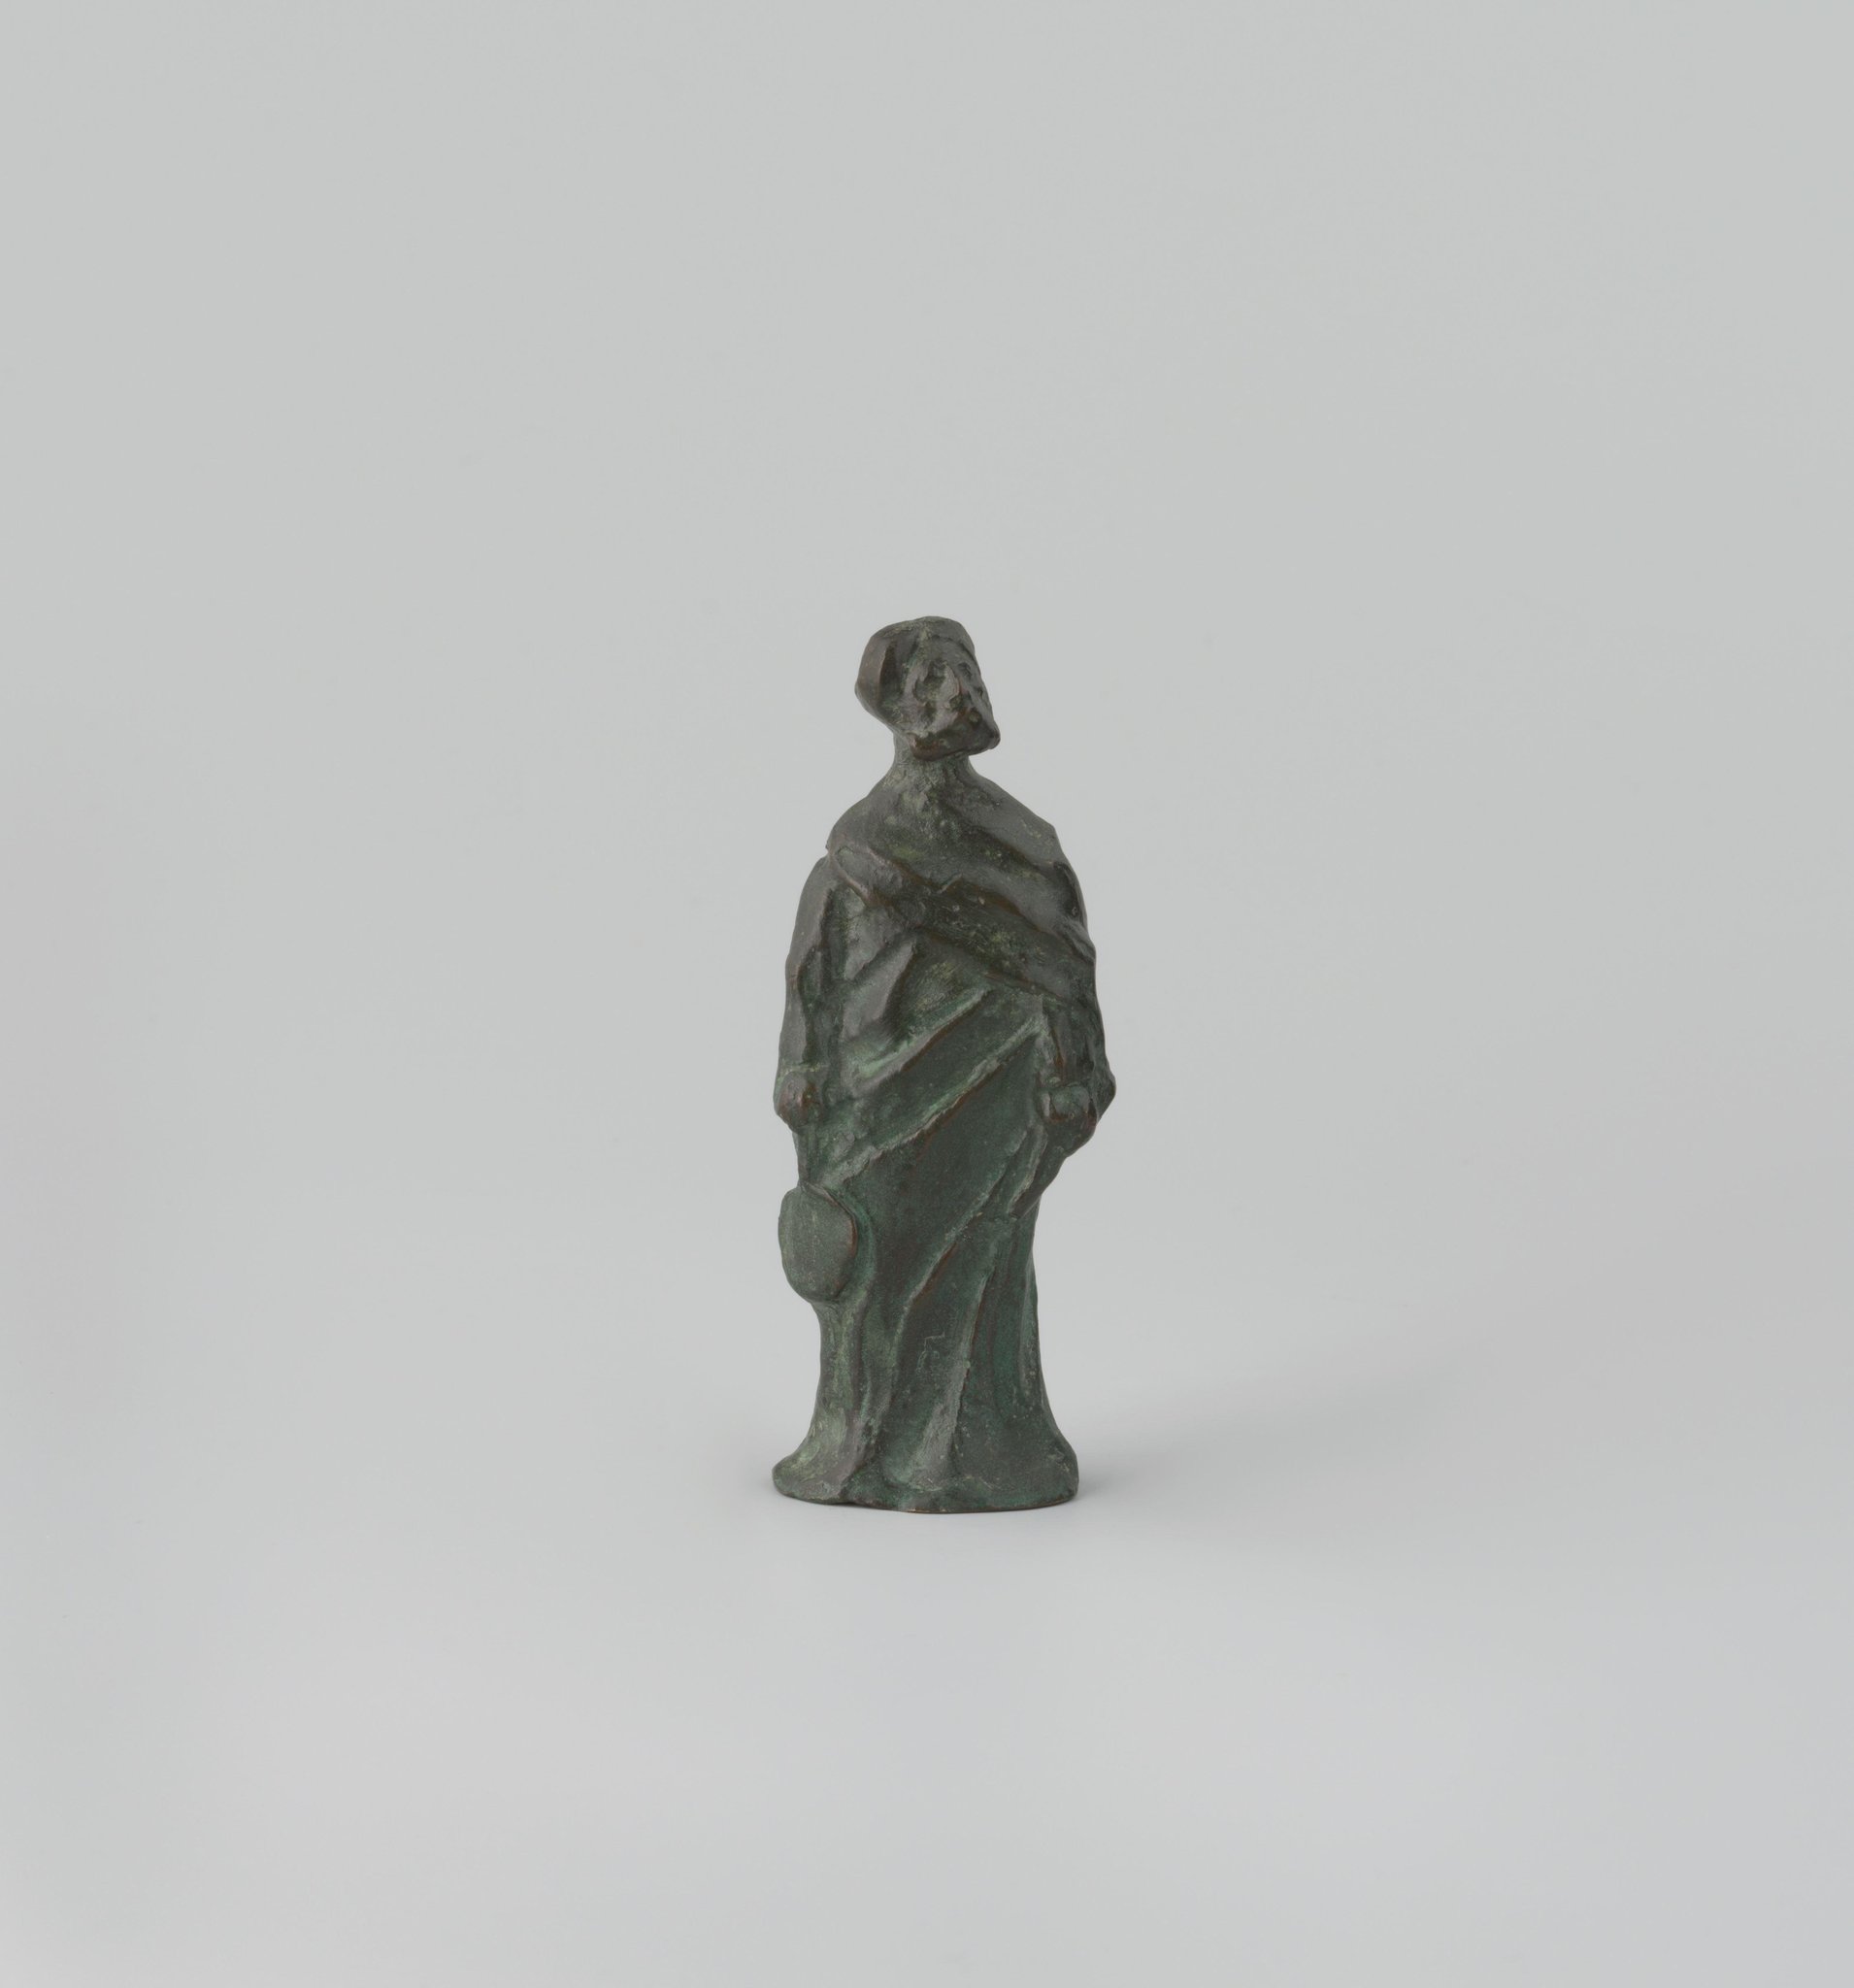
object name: chess piece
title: Pion 4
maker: saar de swart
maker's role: sculptor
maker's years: 1861-1951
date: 1923-1925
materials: bronze, oxide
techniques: casting, lost wax process, patinaed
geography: naples